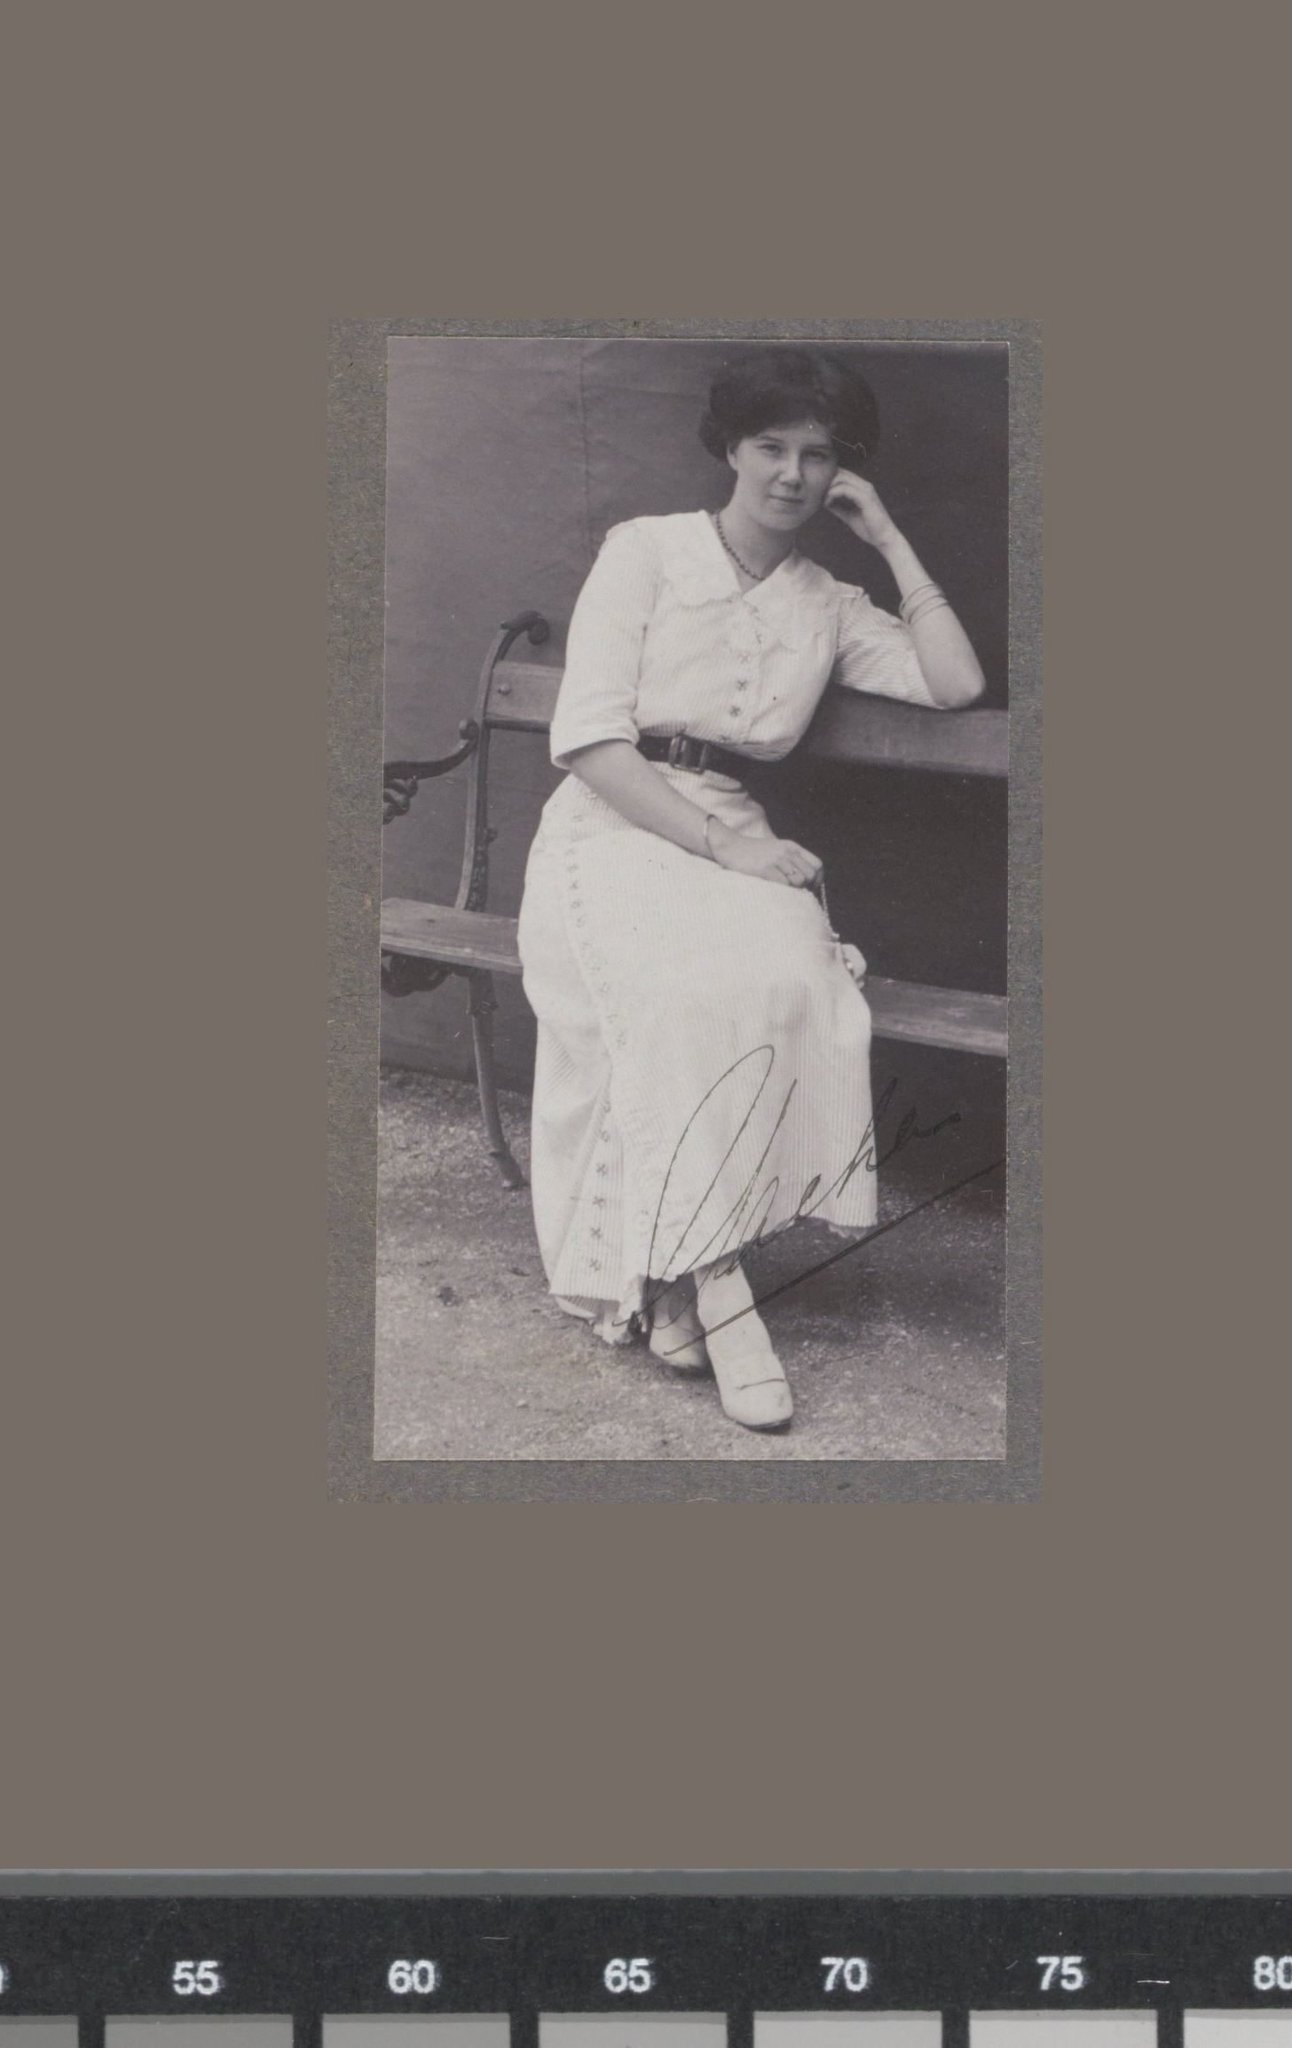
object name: photograph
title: Sacha Croese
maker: Anonymous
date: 1912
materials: photographic support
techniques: photography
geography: suriname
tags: suriname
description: Portret van Sacha Croese, zittend op een tuinbankje, in een fotostudio. Onderdeel van het fotoalbum over het leven van de familie Gonggrijp in Suriname rond 1912.